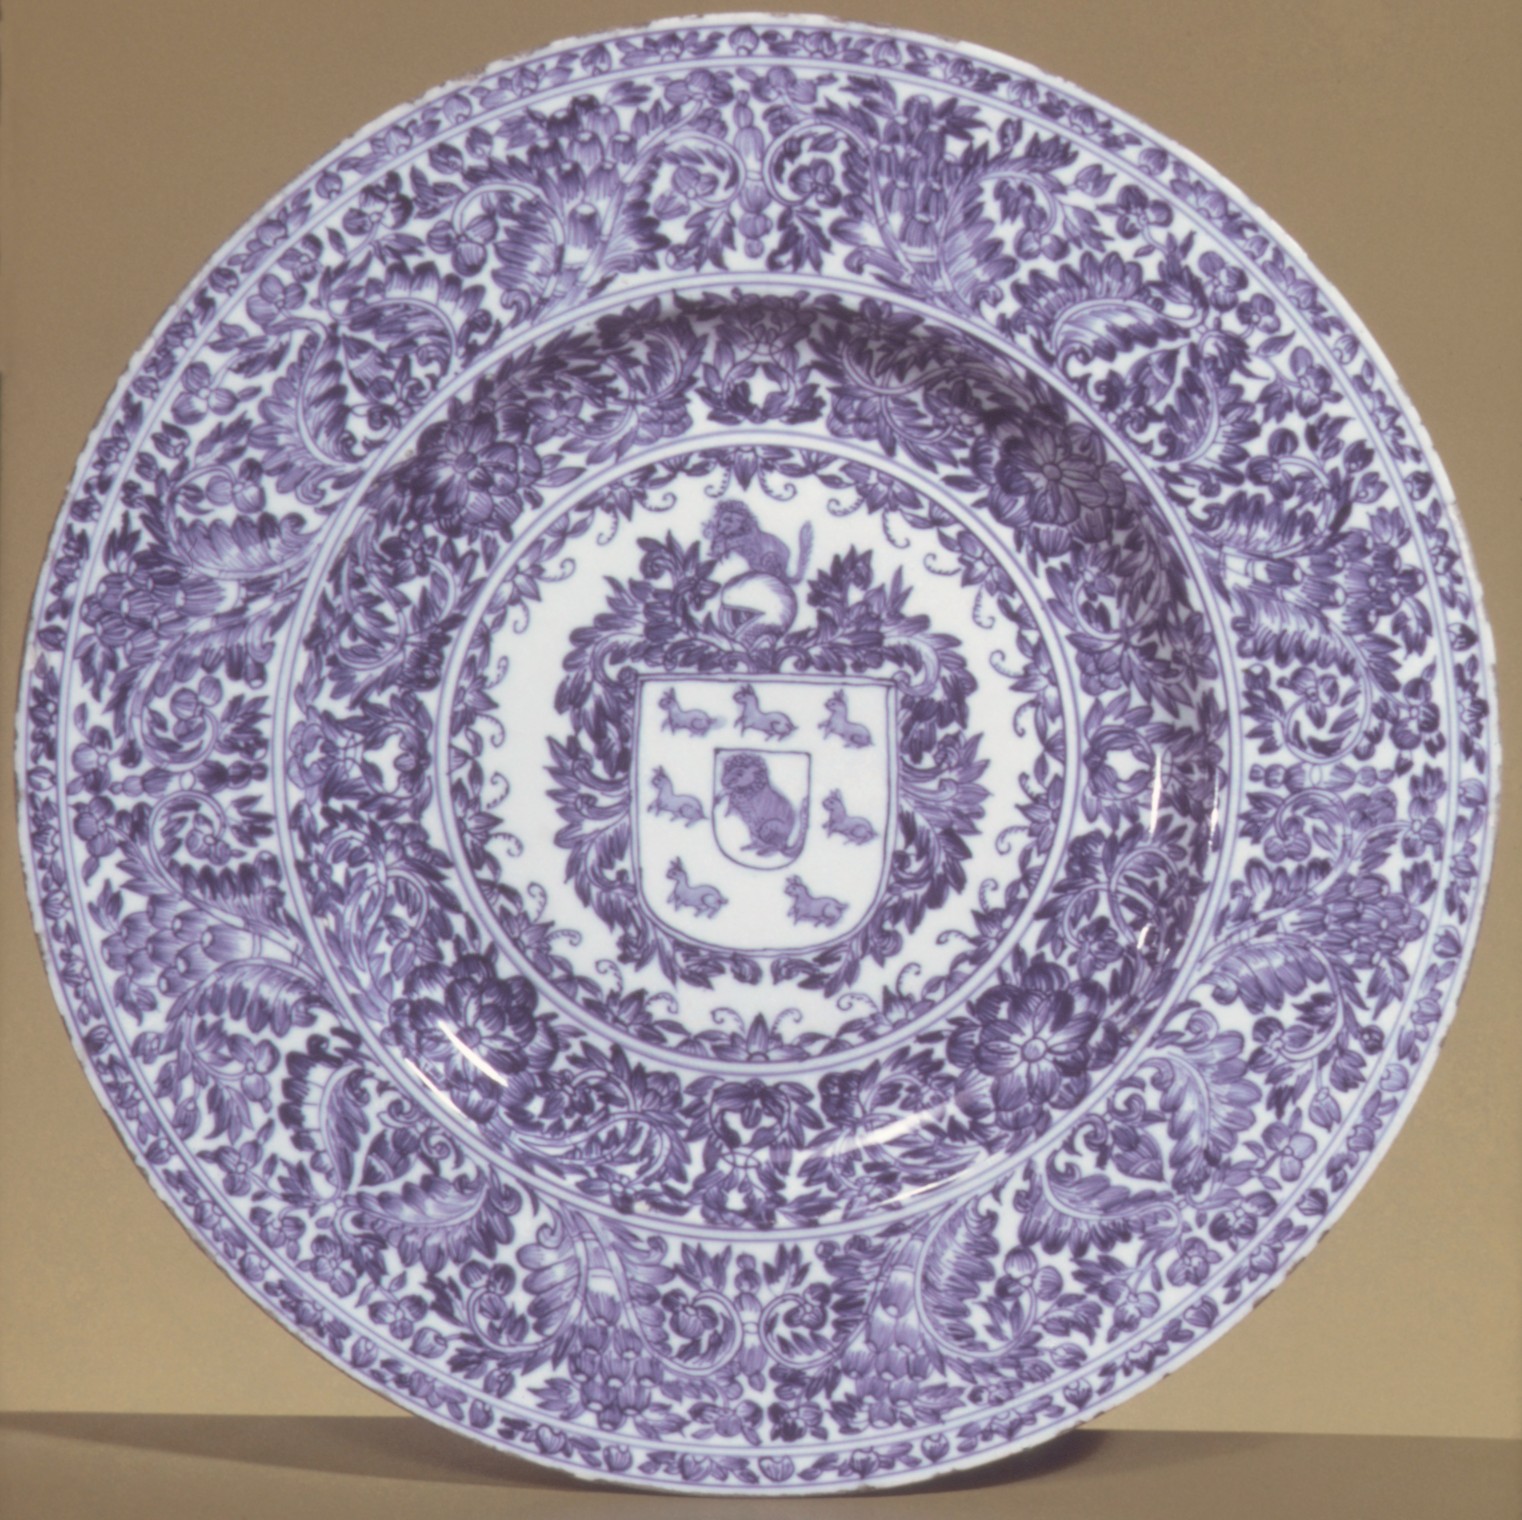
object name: plate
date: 1667-1733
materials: hard paste porcelain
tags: flowers,coat of arms